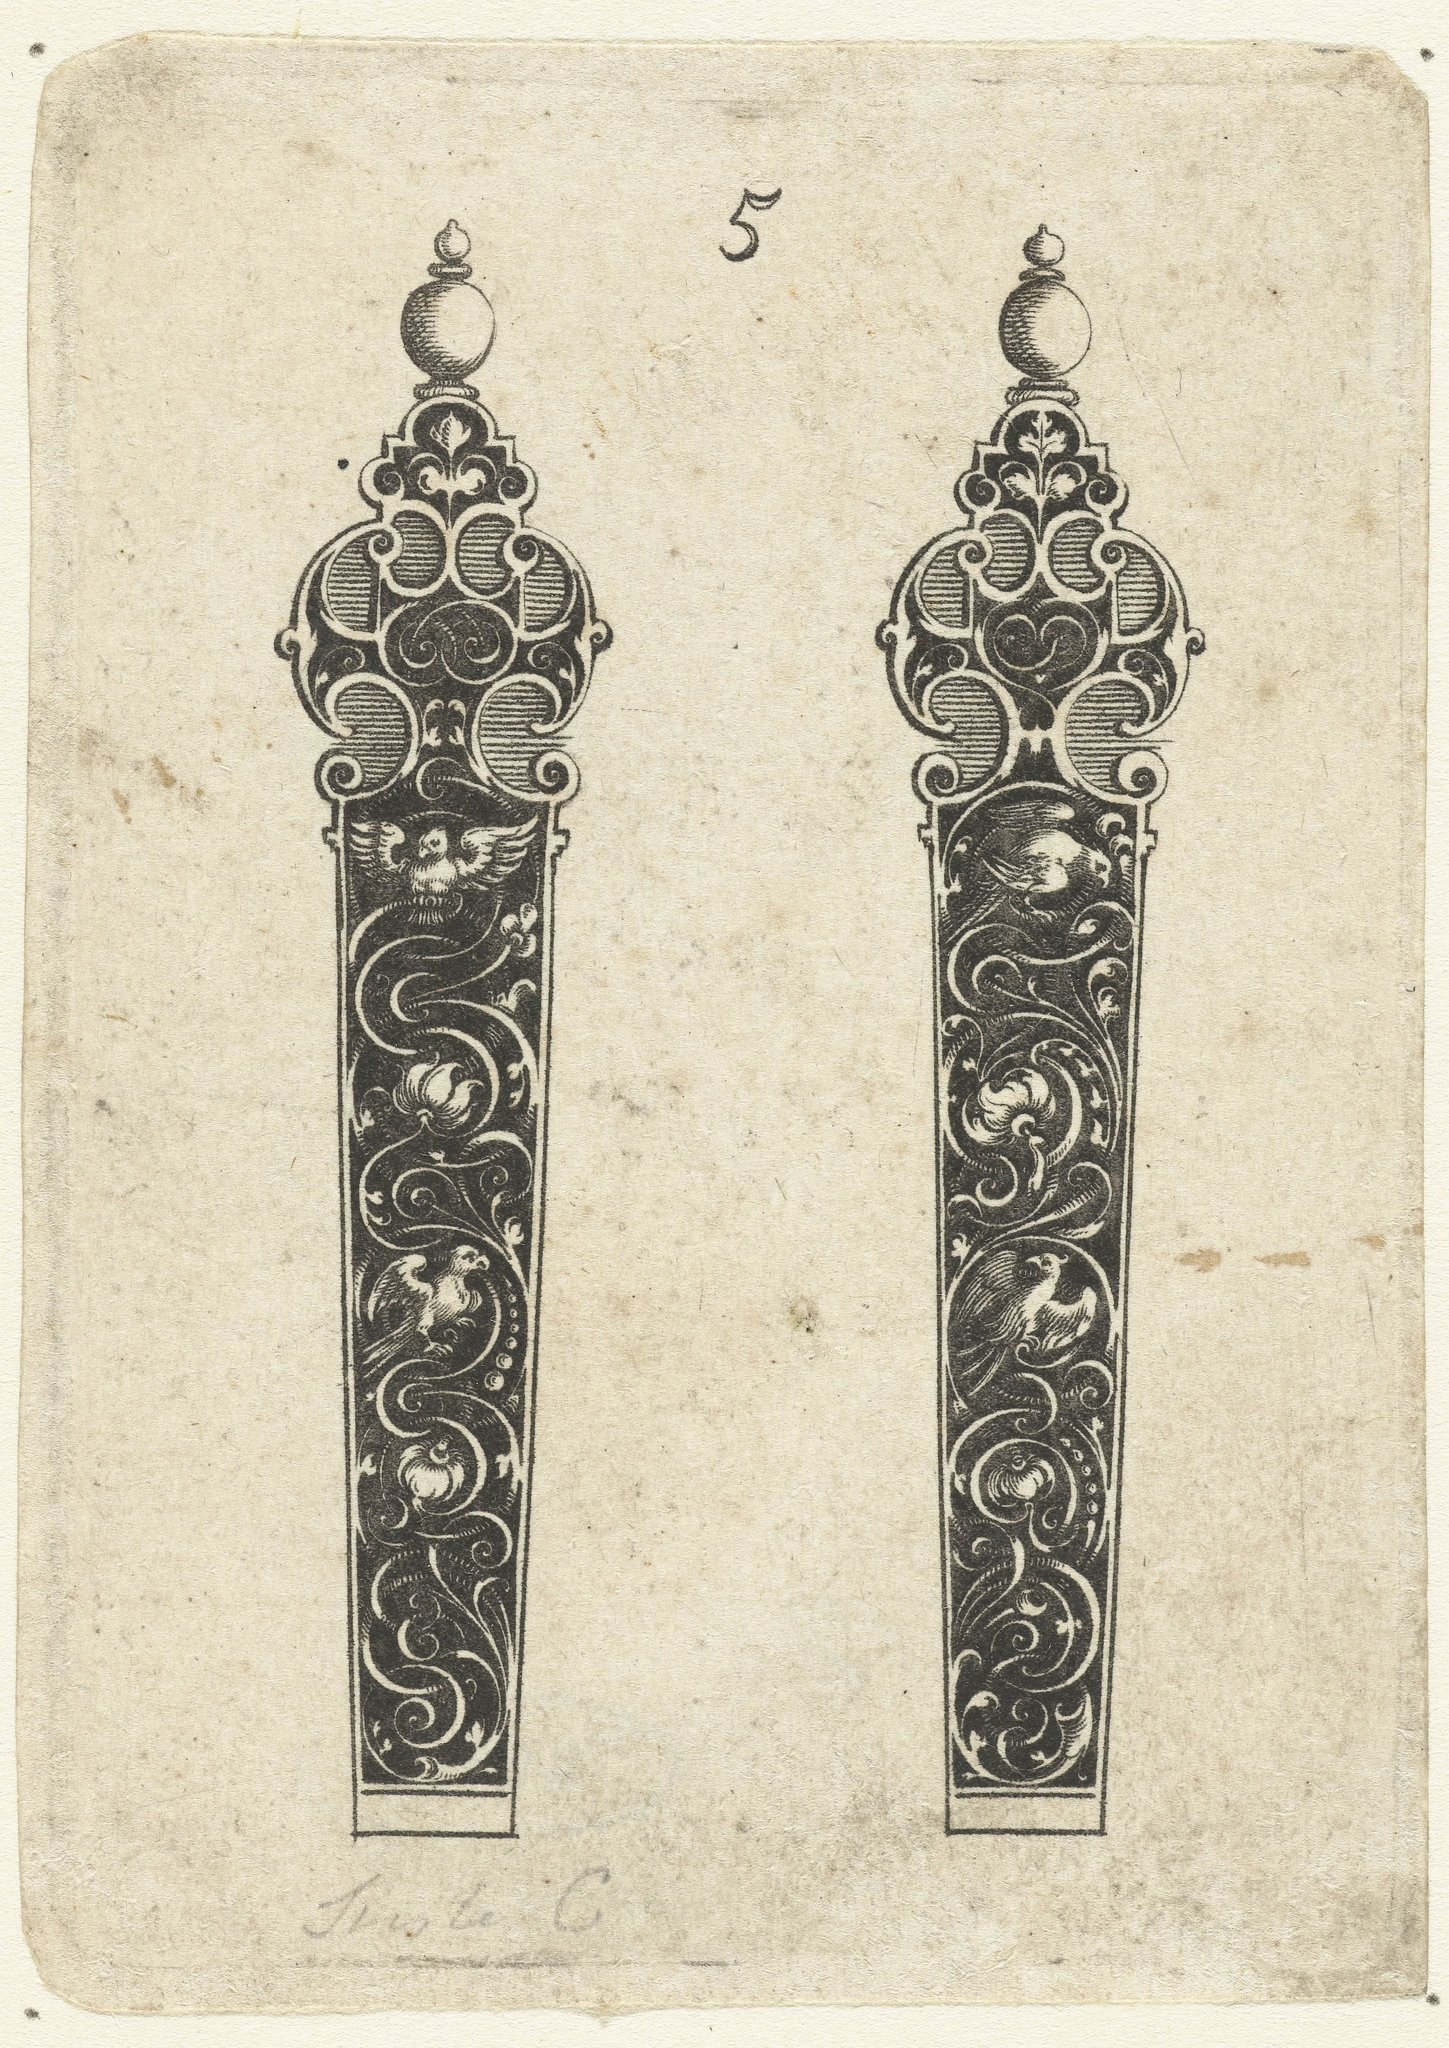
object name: print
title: Messenheften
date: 1597-1656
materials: paper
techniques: etching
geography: amsterdam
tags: birds, table-knife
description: Op elk blad uit deze serie staan twee symmetrische messenheften met bovenaan een kraal. De heften zijn versierd met ranken waartussen zich twee vogels bevinden.